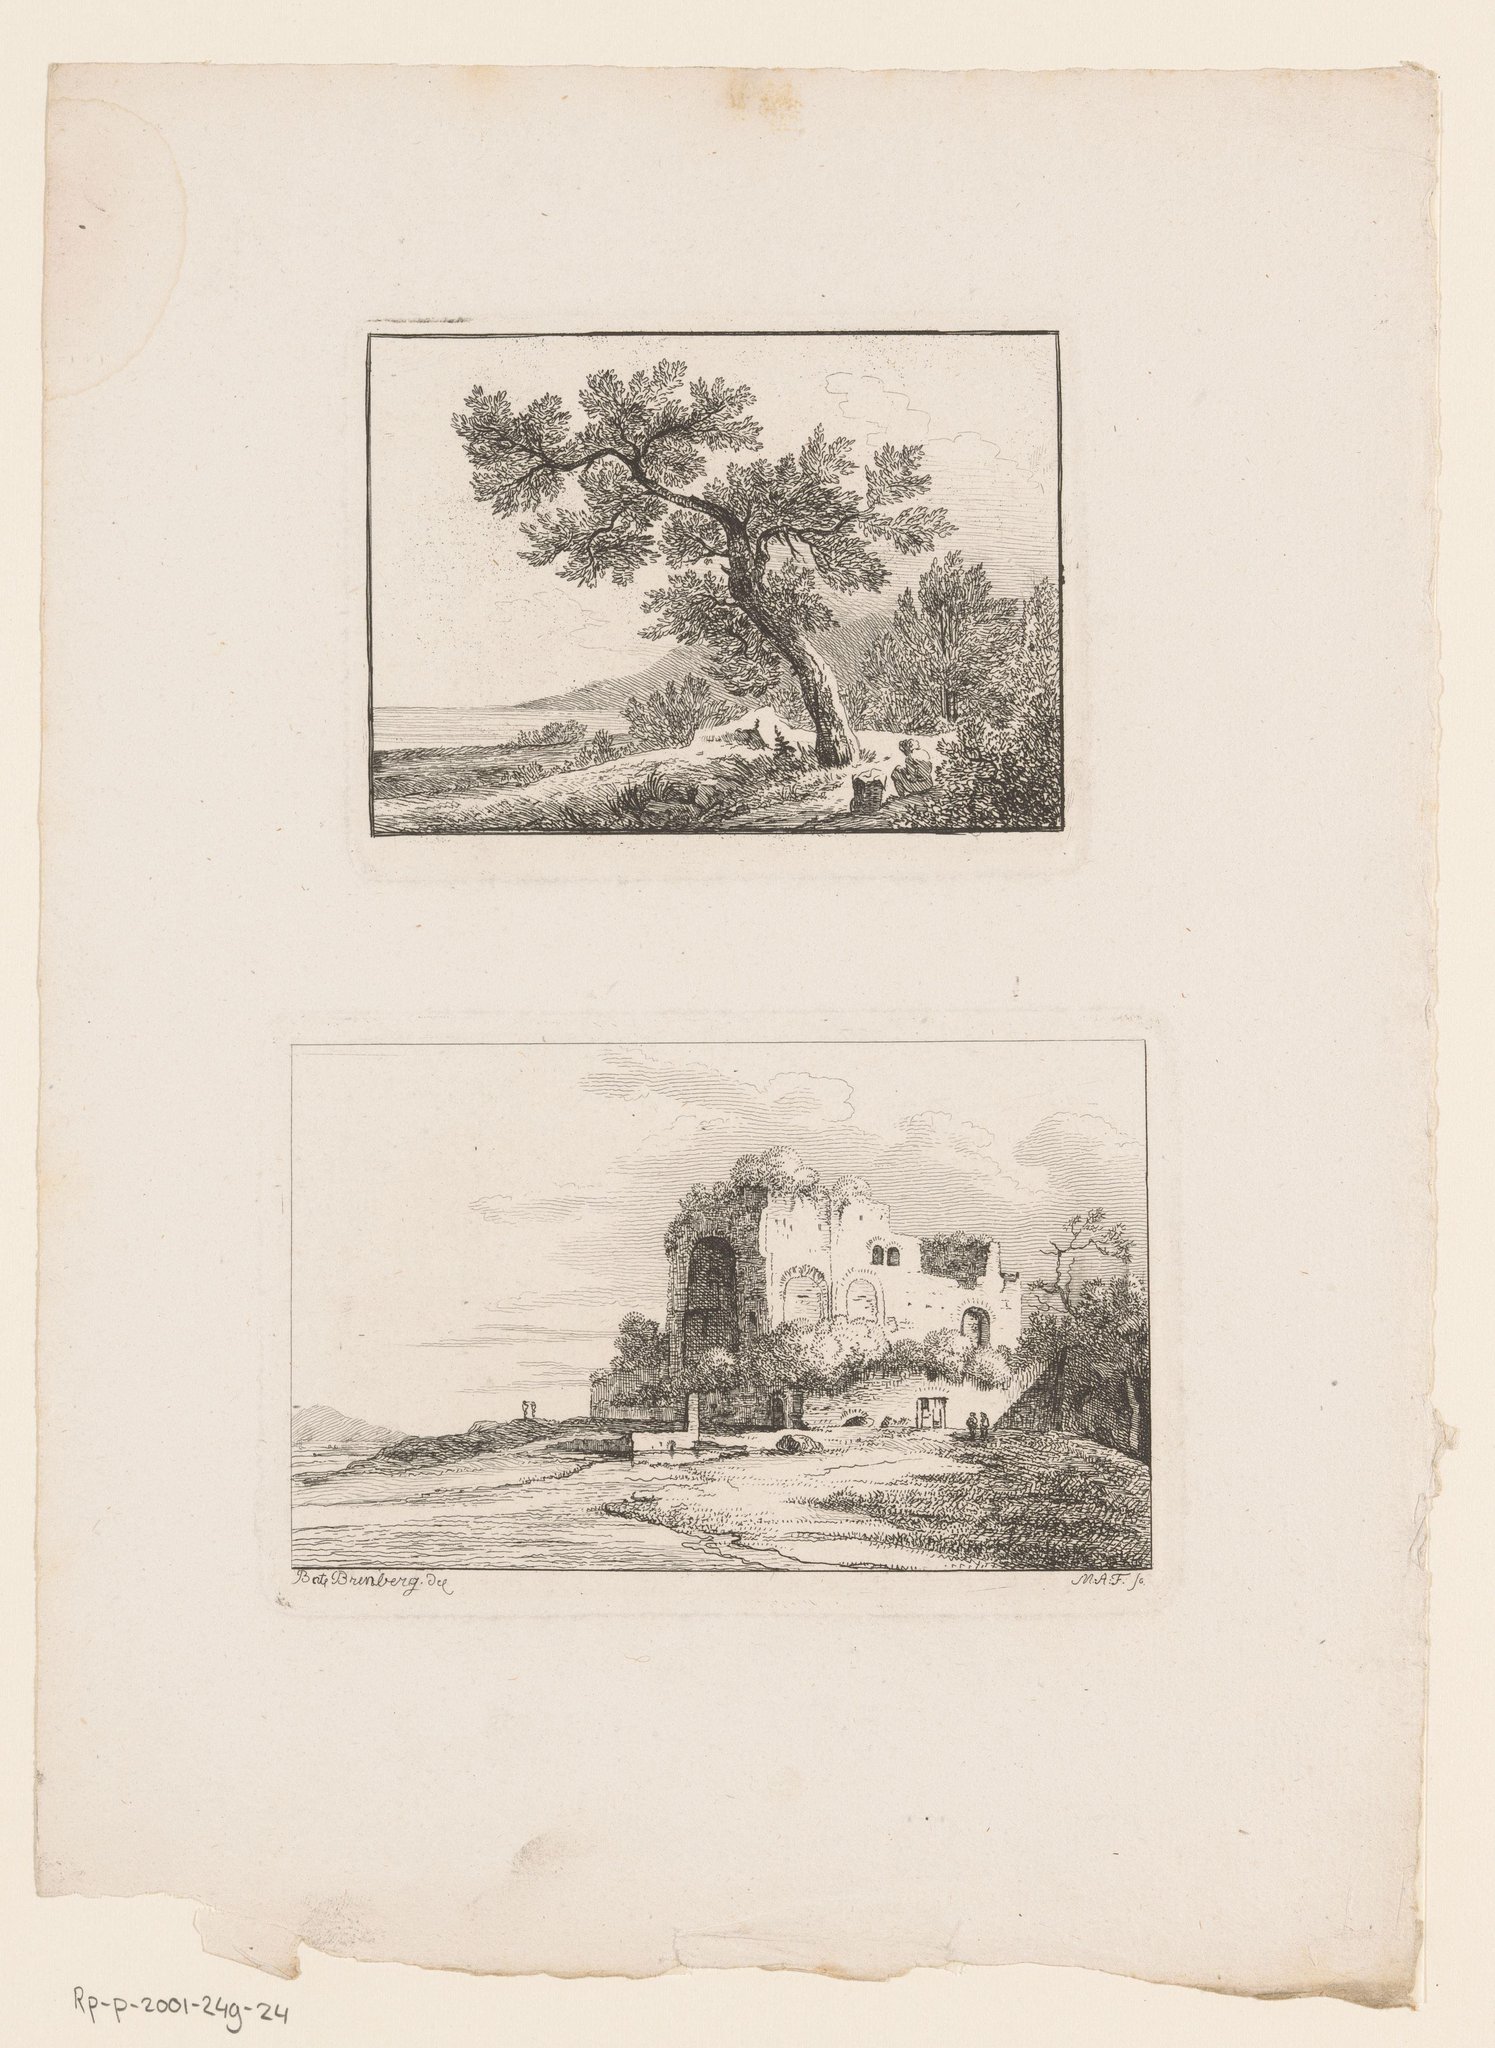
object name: print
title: Mijn eerste etsproeven in een reeks van 28 bladen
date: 1804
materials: paper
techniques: etching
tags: trees, landscape with ruins, landscapes (+ landscape with figures, staffage)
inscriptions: collector's mark: Lugt 2228, collector's mark: Lugt 2760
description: De originele prentserie bevat 40 prenten op 28 bladen. Het RMA heeft 33 prenten op 22 bladen in de collectie.